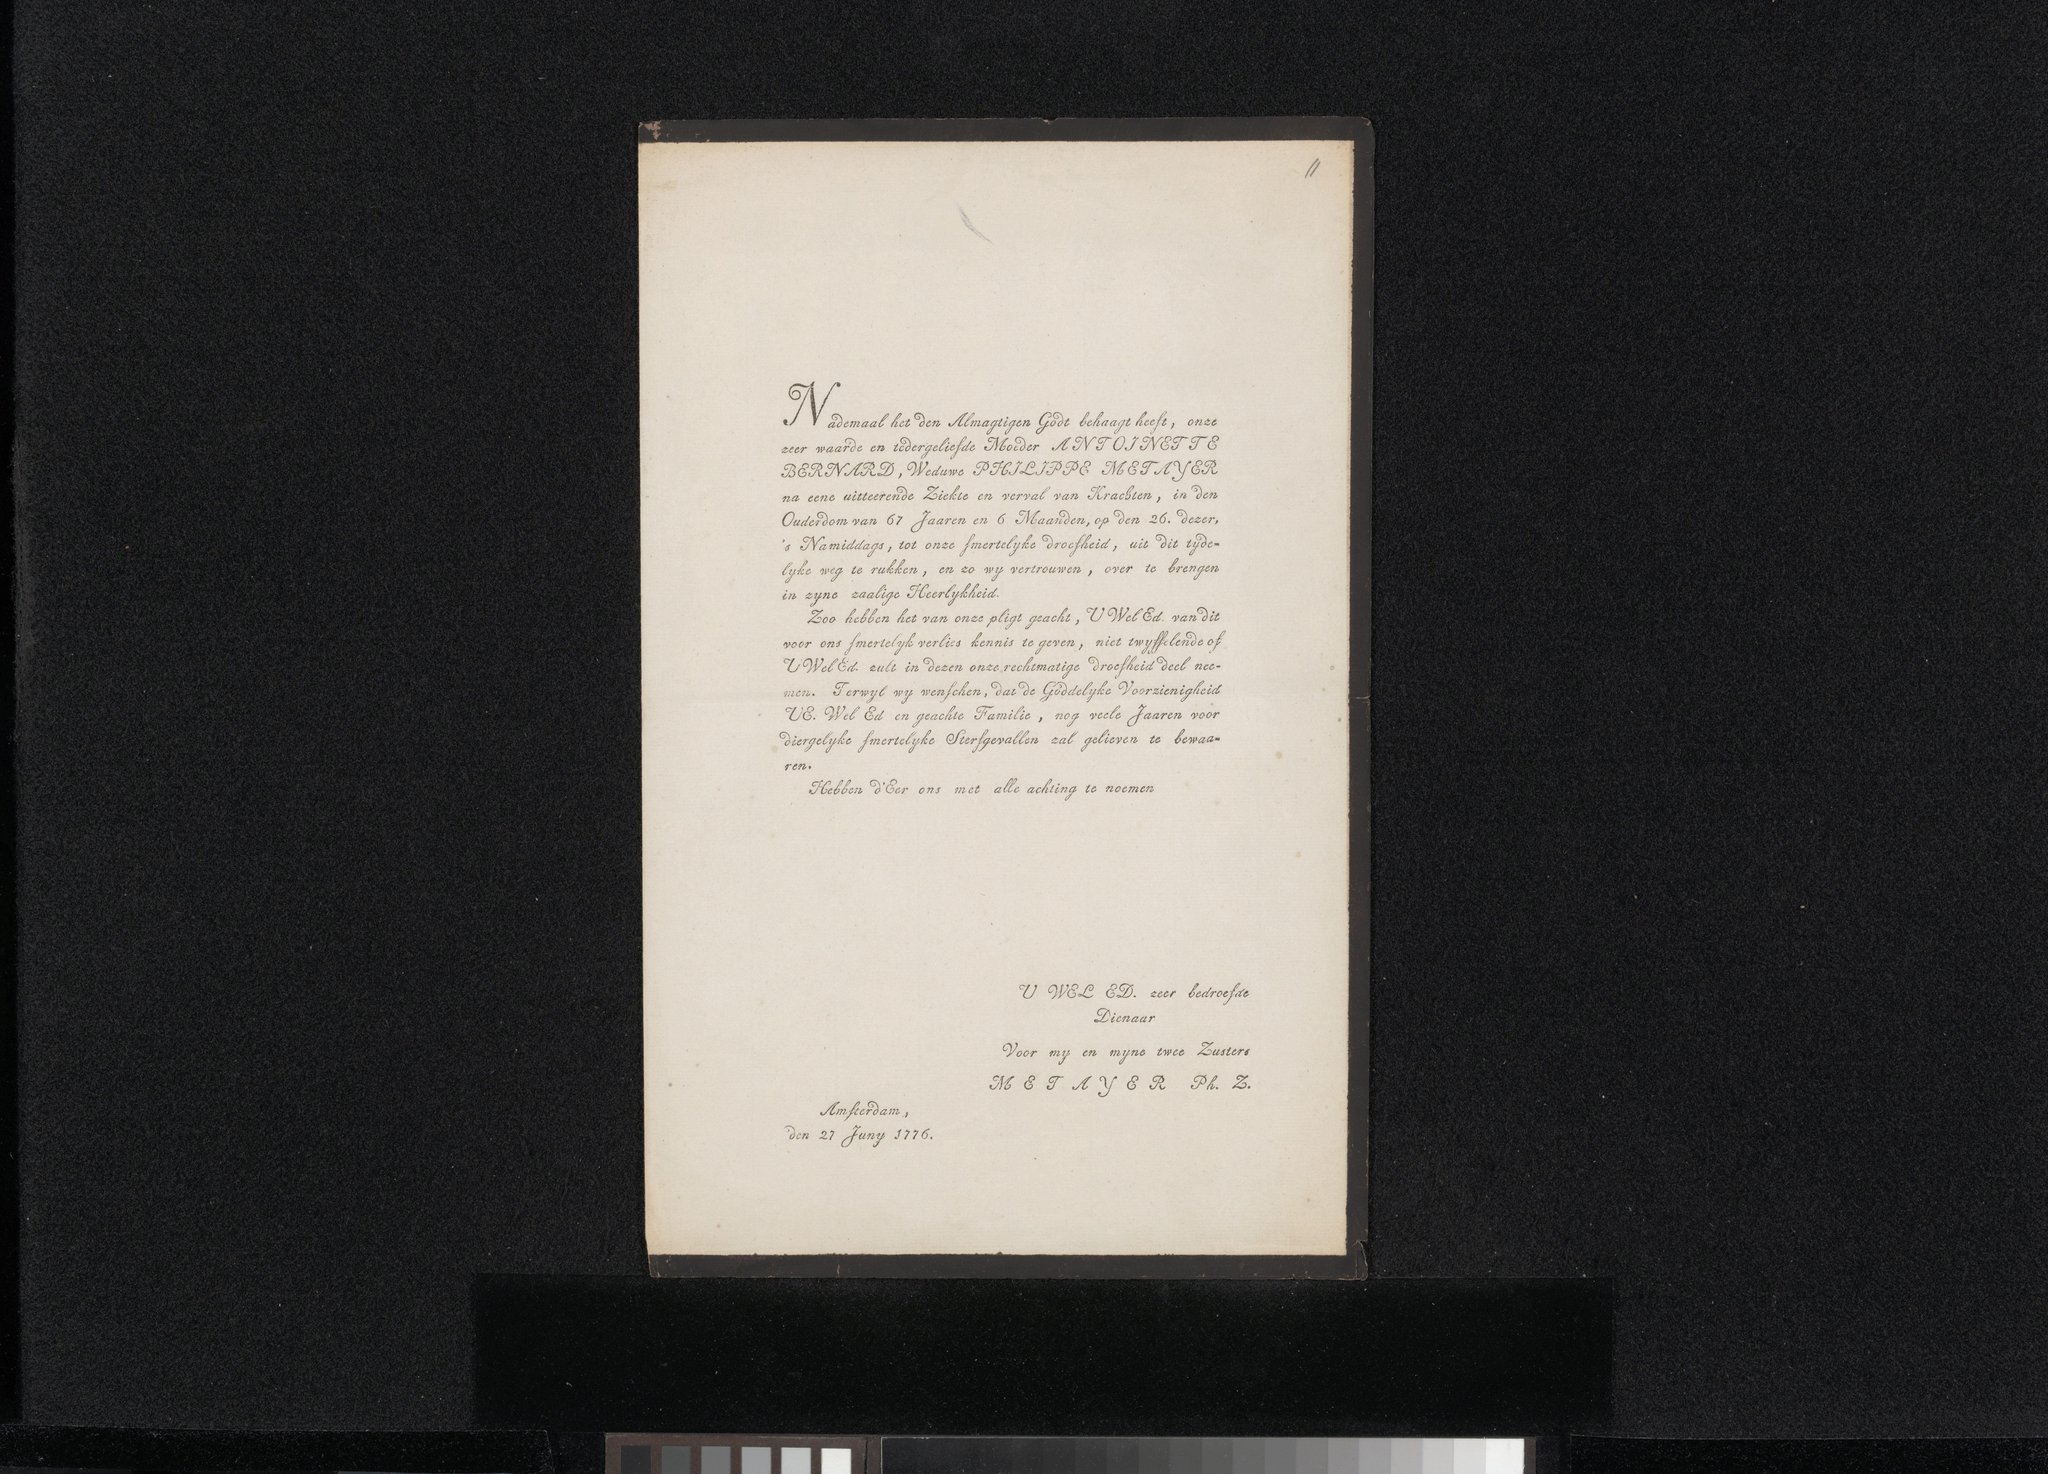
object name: overlijdensbericht, overlijdensadvertentie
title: Overlijdensbericht betreffende Johanna Magdalena Schnetzler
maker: philippe métayer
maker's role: goldsmith, print maker, silversmith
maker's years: 1697-1763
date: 1776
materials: paper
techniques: printing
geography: amsterdam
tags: johanna magdalena schnetzler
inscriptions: watermark, collector's mark: Lugt 2233